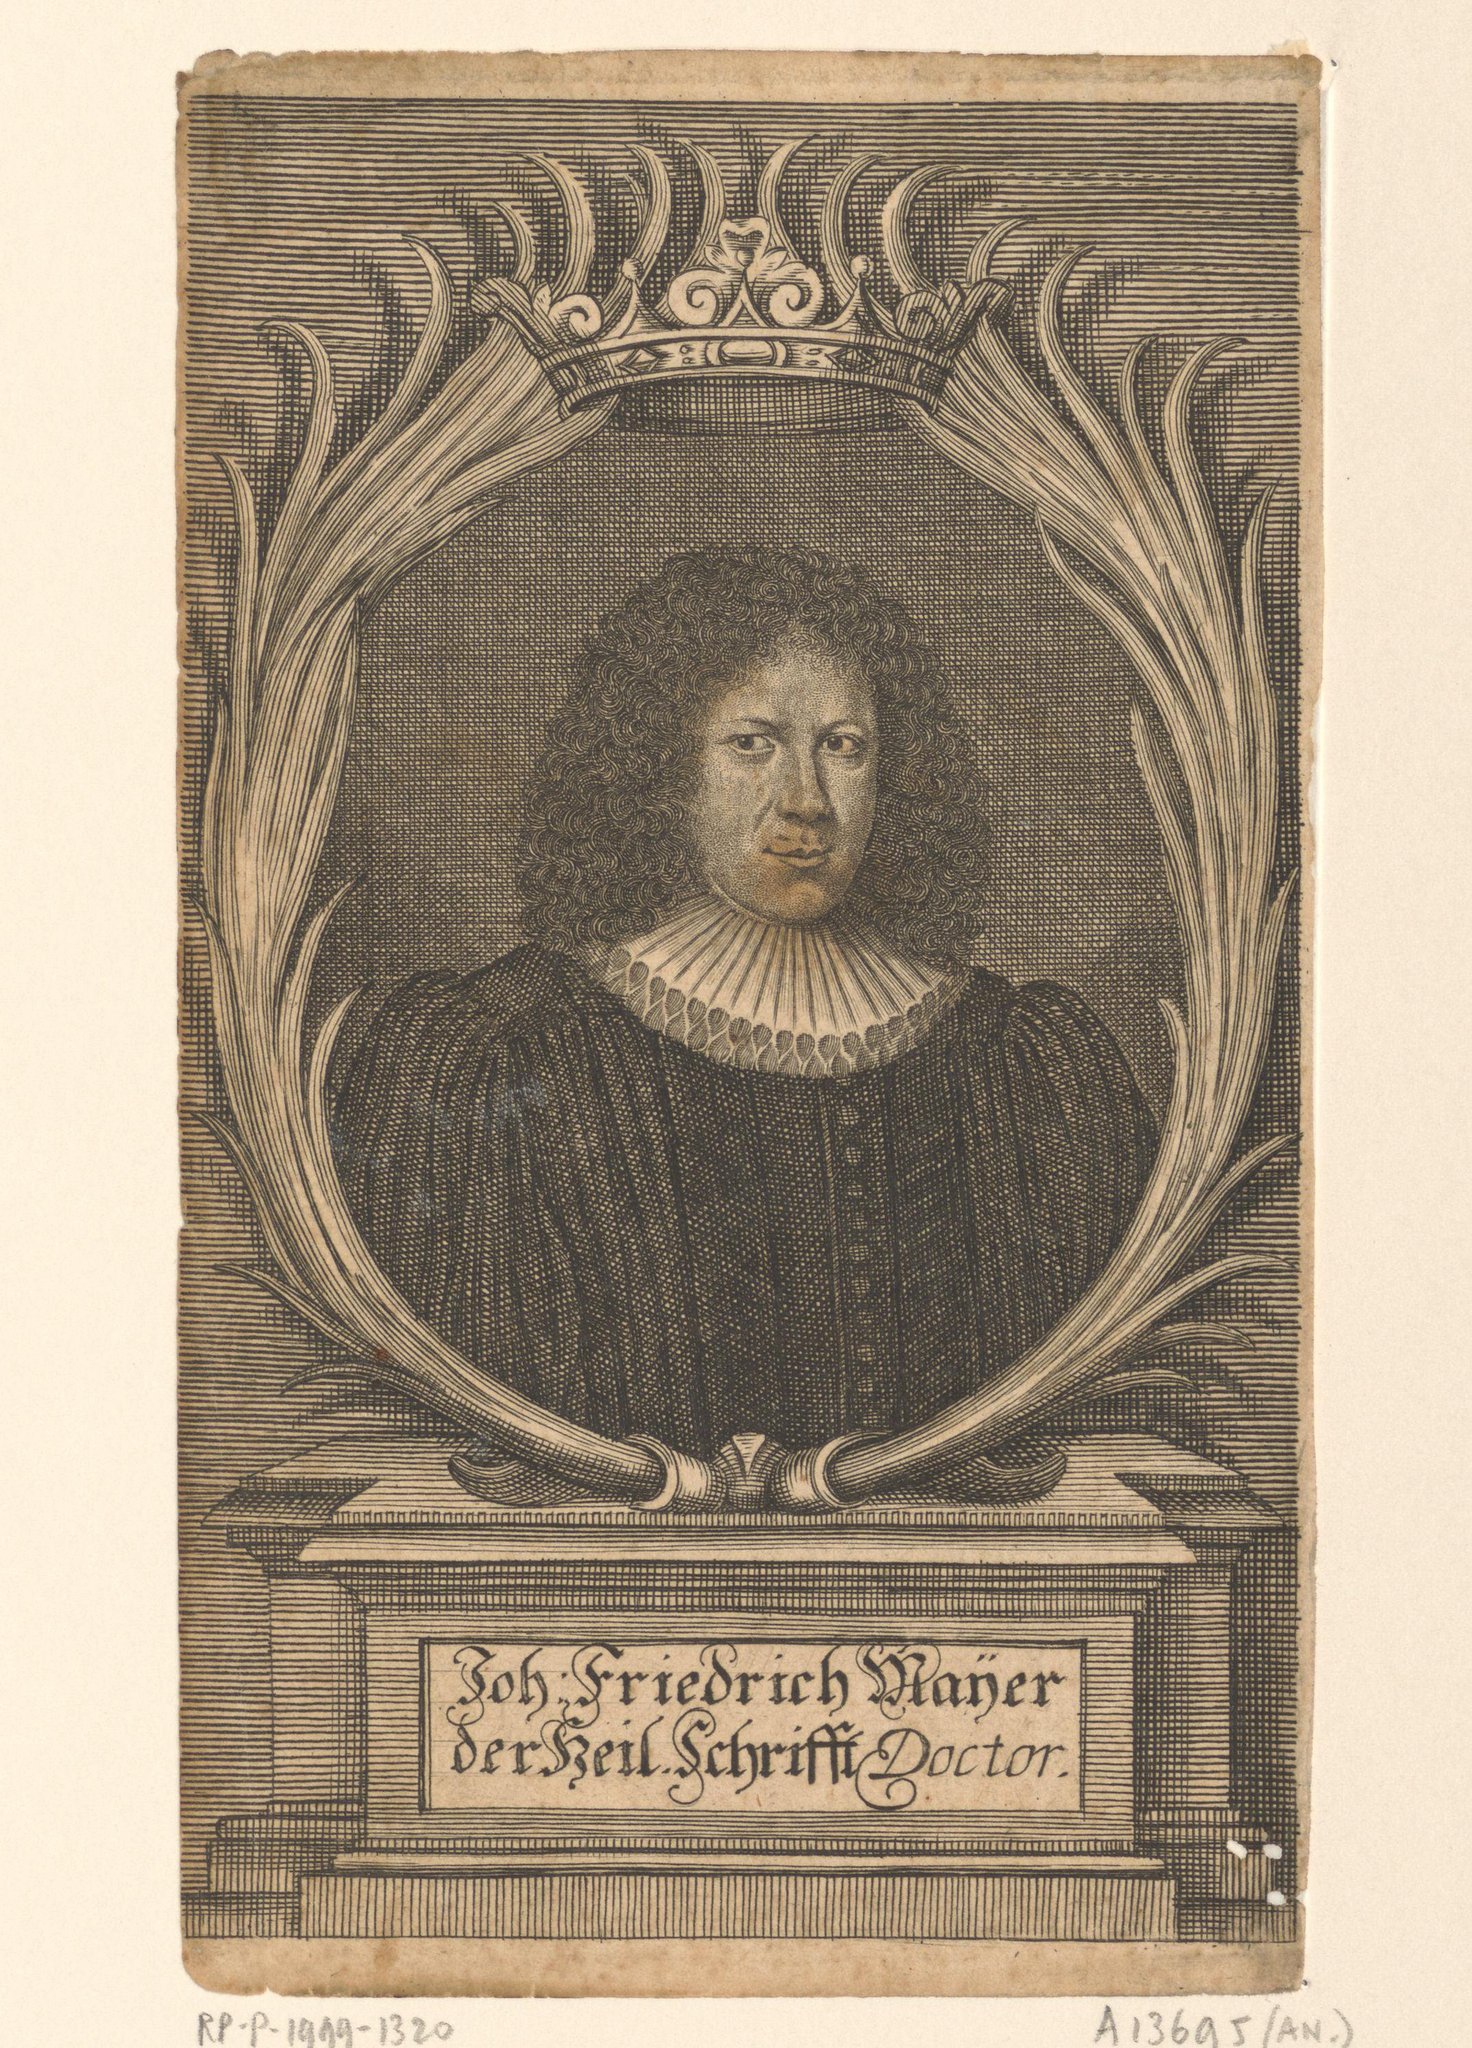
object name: print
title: Portret Johann Friedrich Mayer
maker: Anonymous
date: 1673-1720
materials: paper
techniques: engraving, etching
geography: germany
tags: theologian, ornament ~ medallion, historical persons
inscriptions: collector's mark: Lugt 2760, collector's mark: Lugt 2228